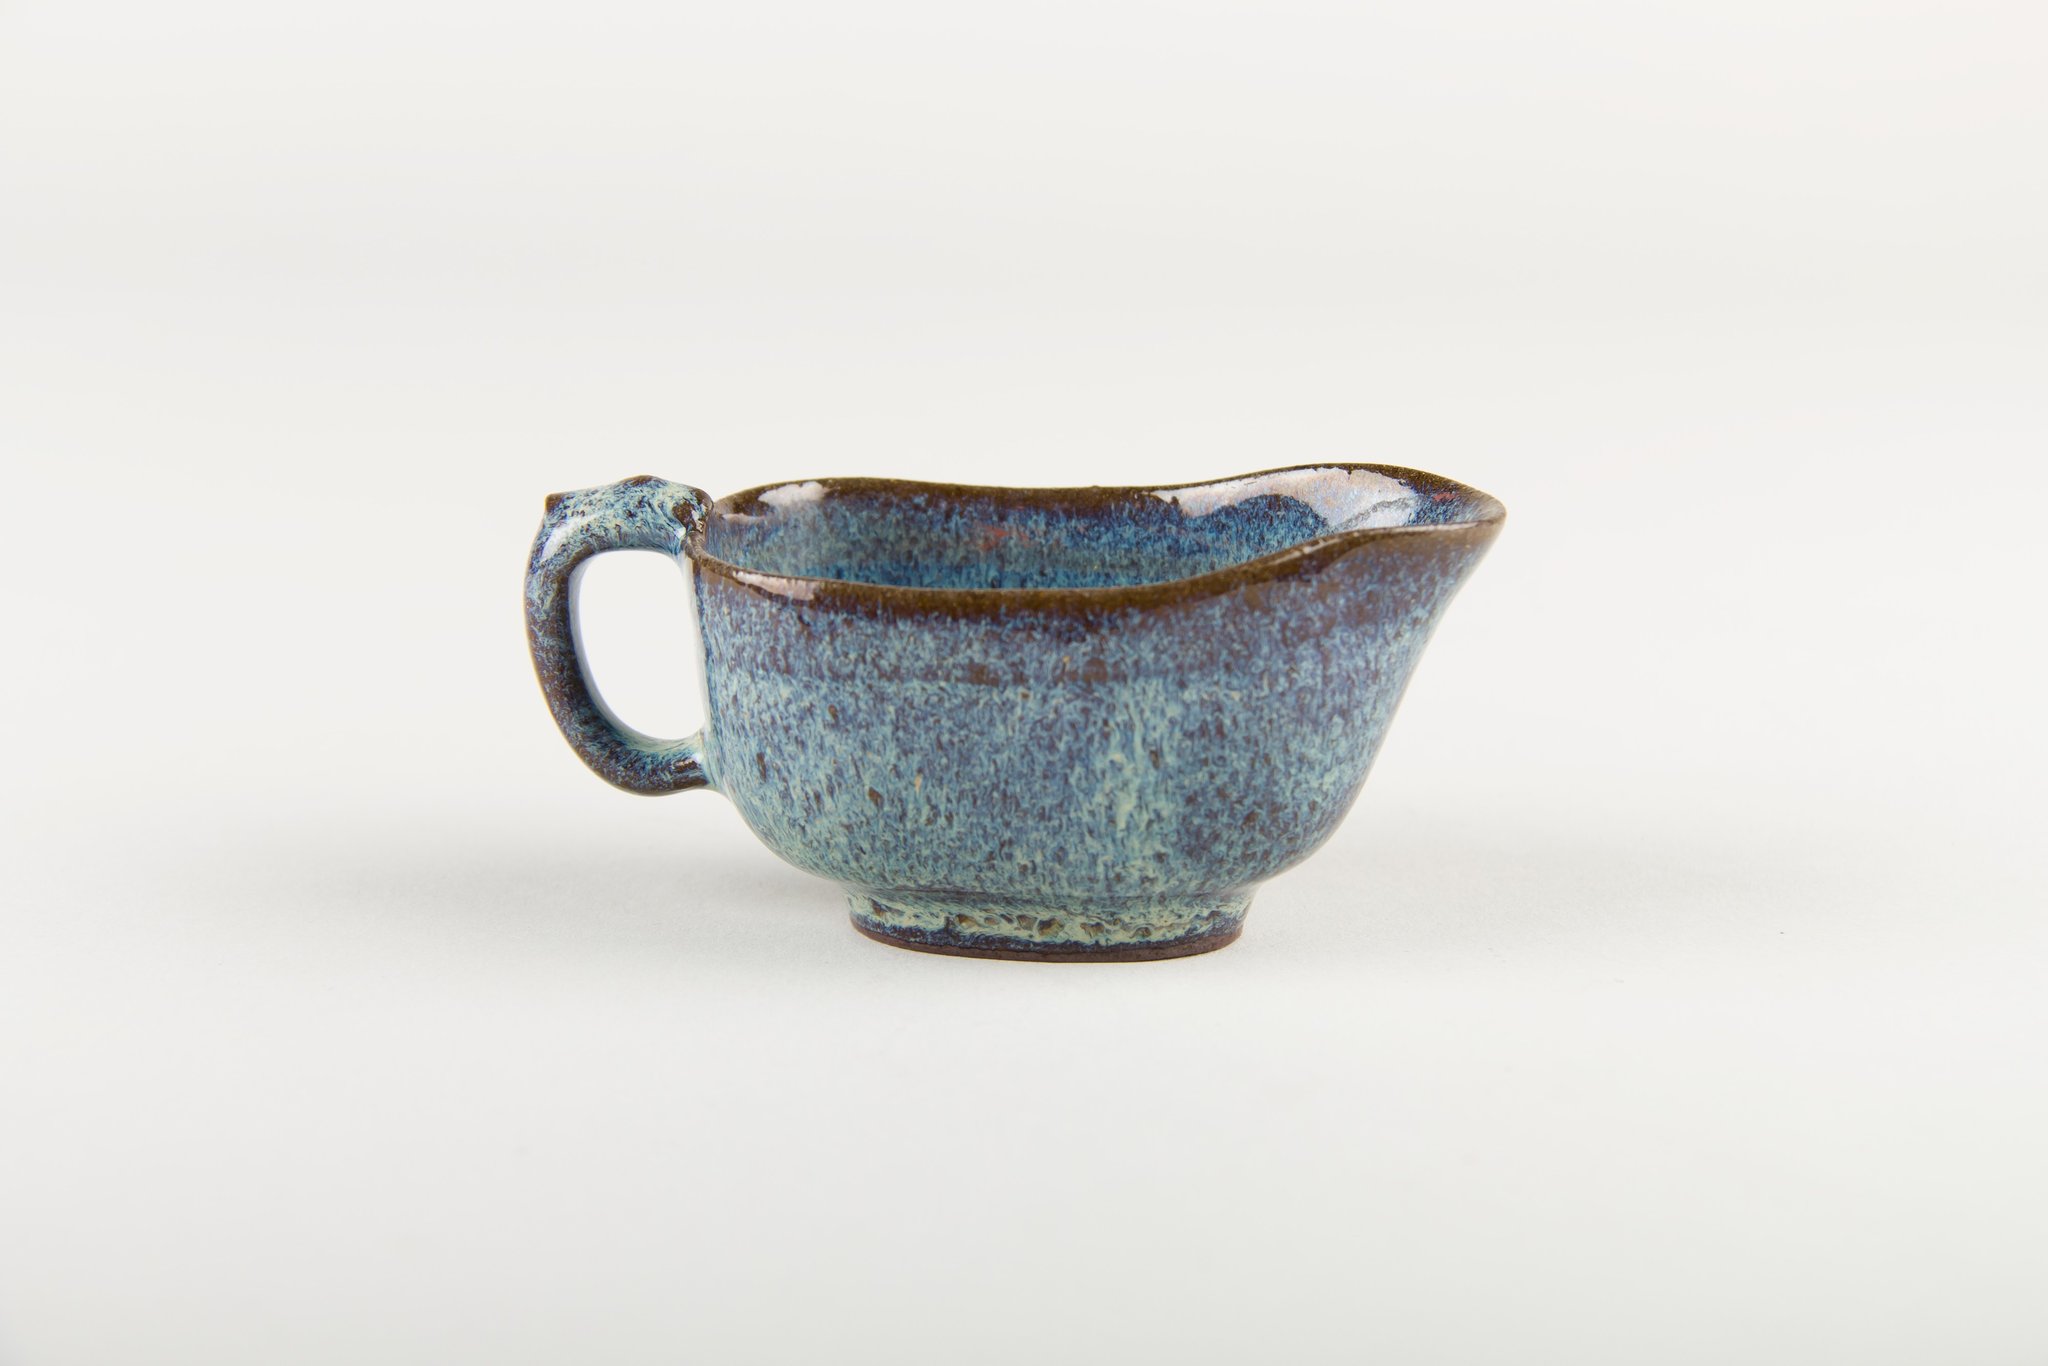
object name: water vessel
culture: chinese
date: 1644-1911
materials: glaze, stoneware